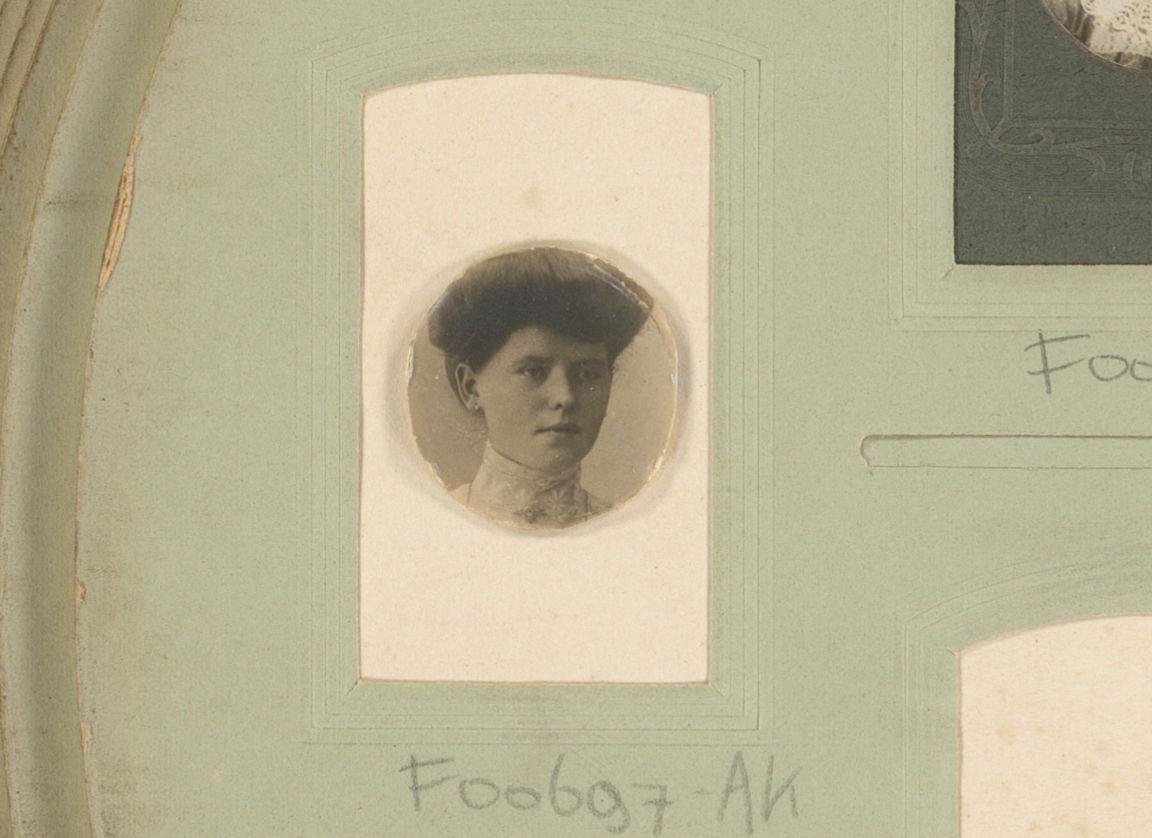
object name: photograph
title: Portret van een vrouw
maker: Anonymous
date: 1890-1910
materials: photographic support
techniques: gelatin silver print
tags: adult woman, historical persons